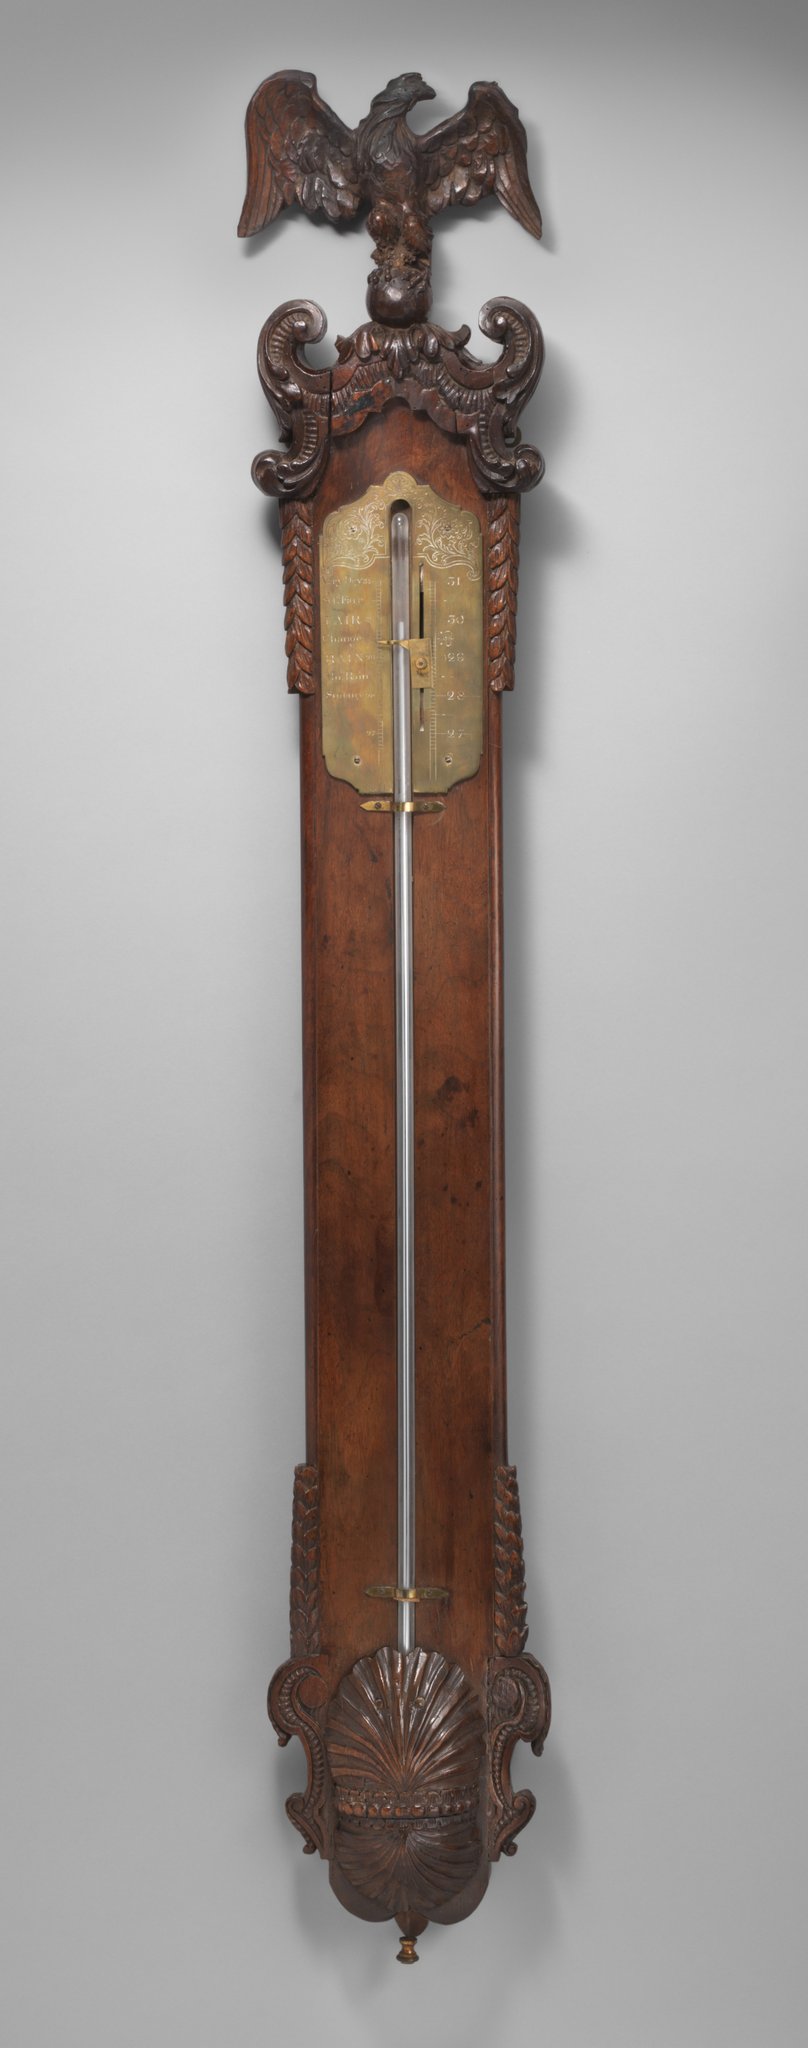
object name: torricellian barometer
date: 1730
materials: mercury, wood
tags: eagles